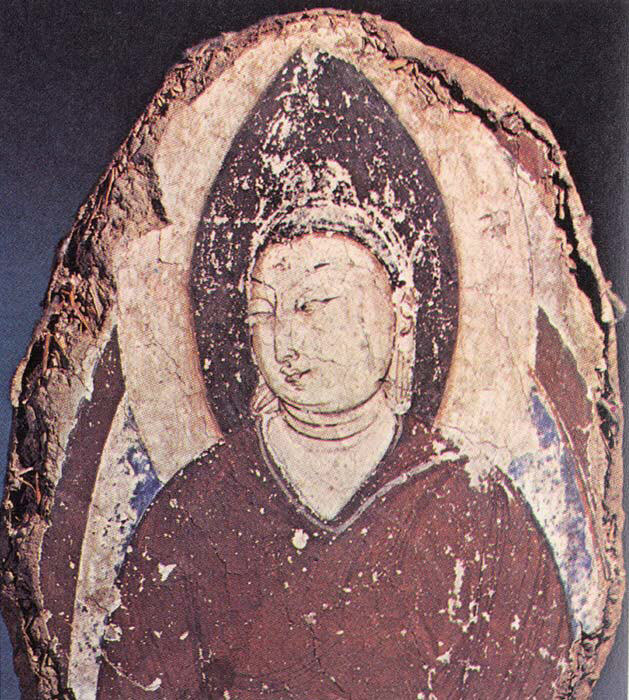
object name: wall painting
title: Buddha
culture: xinjiang uyghur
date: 501-600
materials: mud, pigment, plaster